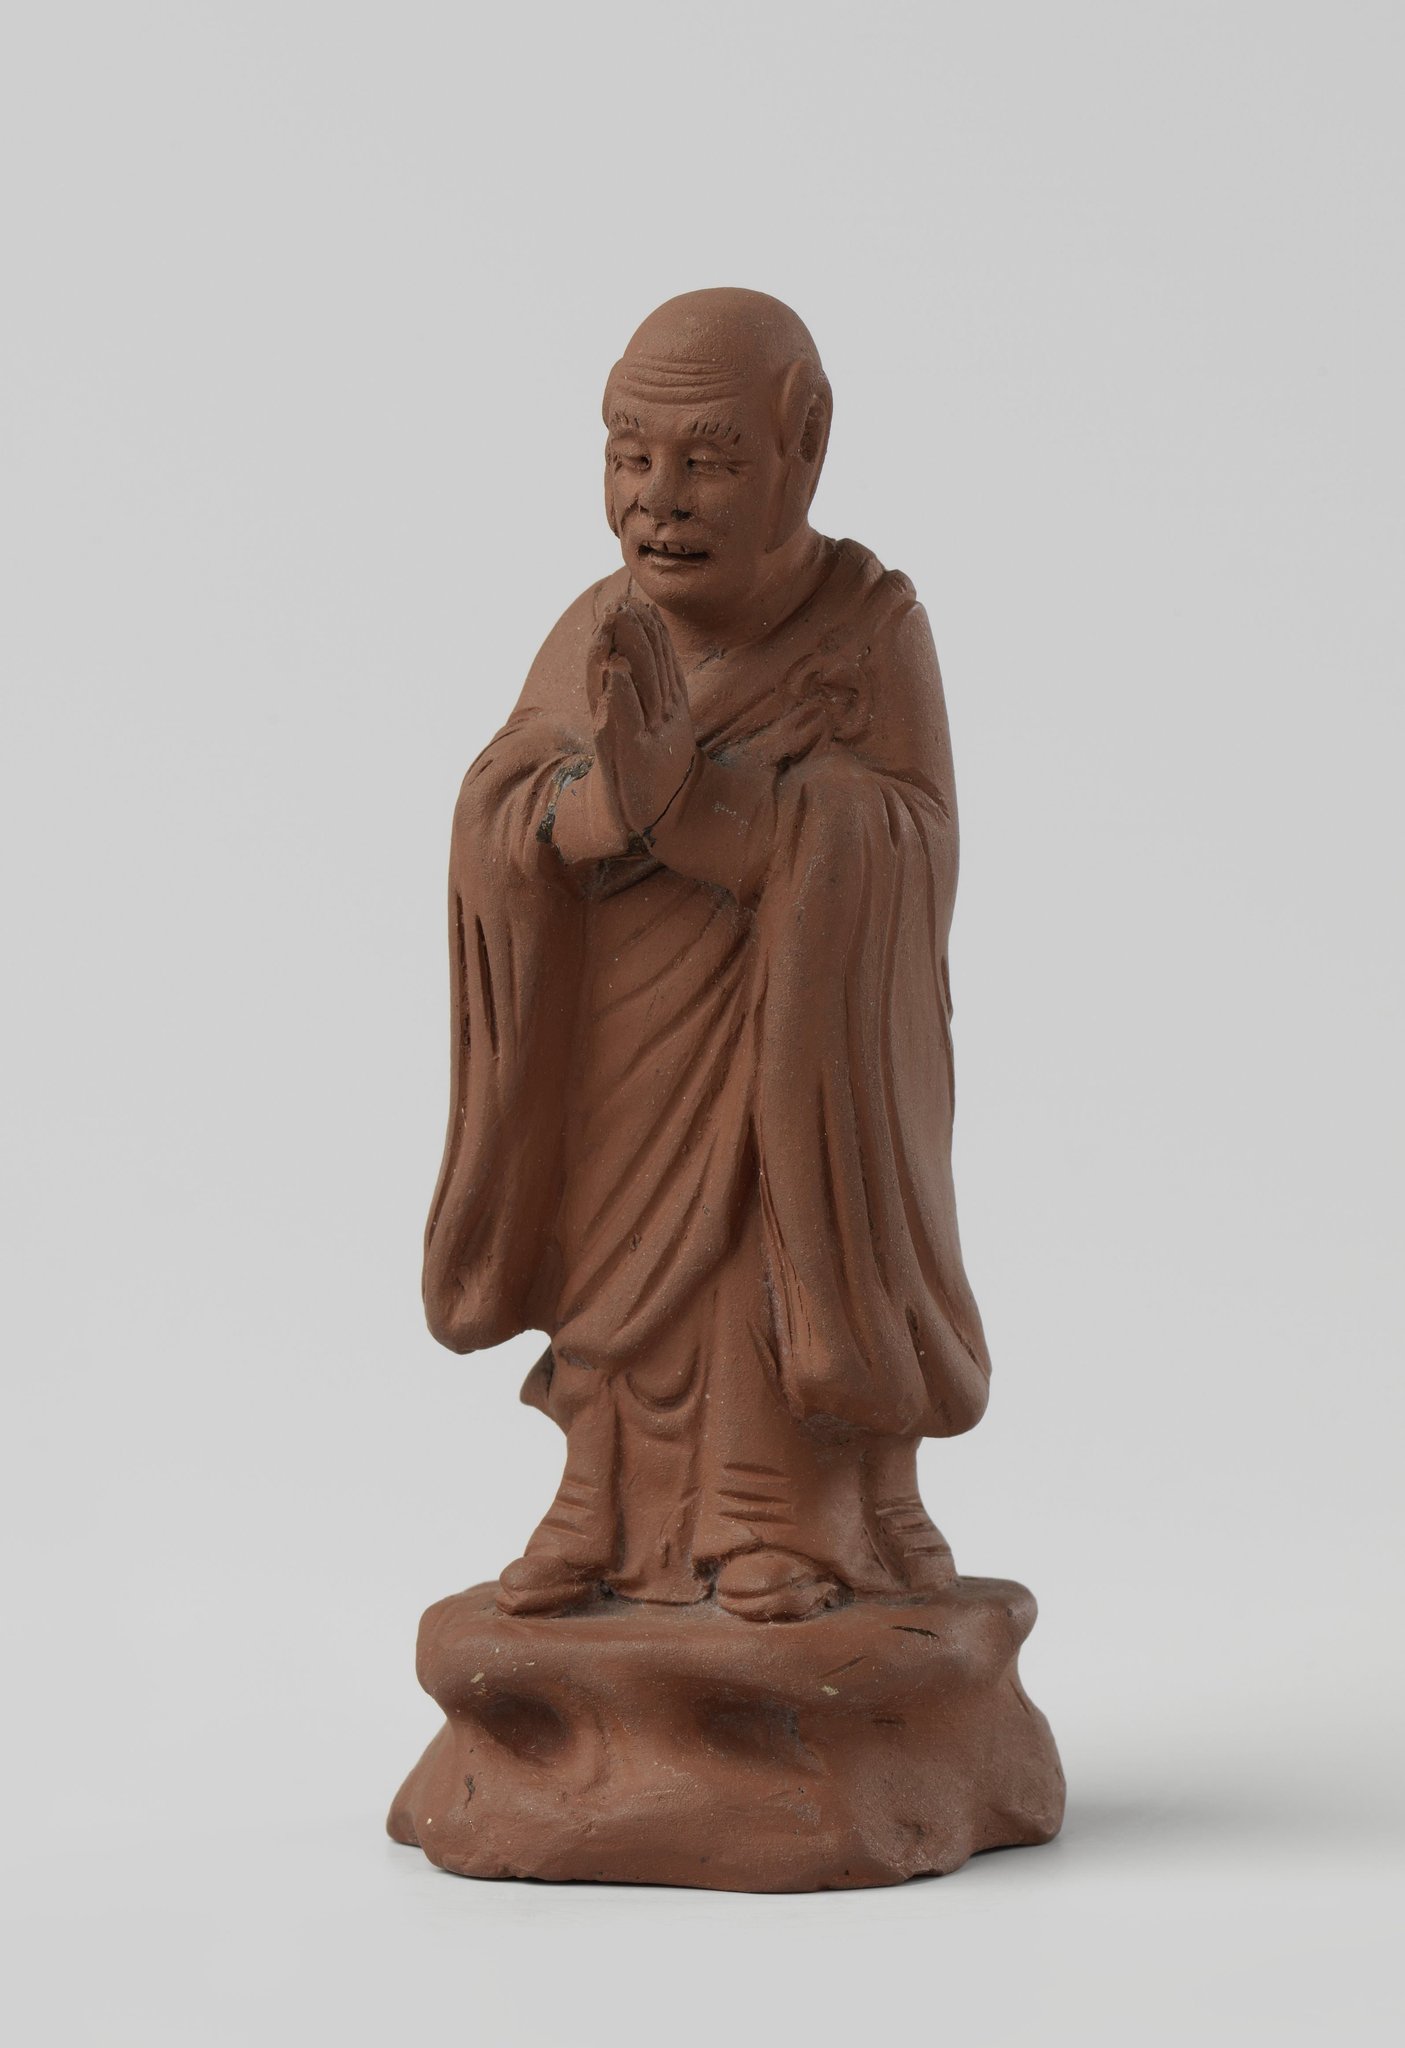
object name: decoratief object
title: Figurines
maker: Anonymous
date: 1680-1720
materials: earthenware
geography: delft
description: Delft potters used the same moulds for figures in red stoneware as they did for those in the better-known blue-and-white earthenware. These figurines demonstrate how Chinese forms were reimagined in an independent way. The model for these figures may have been the Buddhist deity Arhat, only here reinterpreted and moulded in Dutch clay.